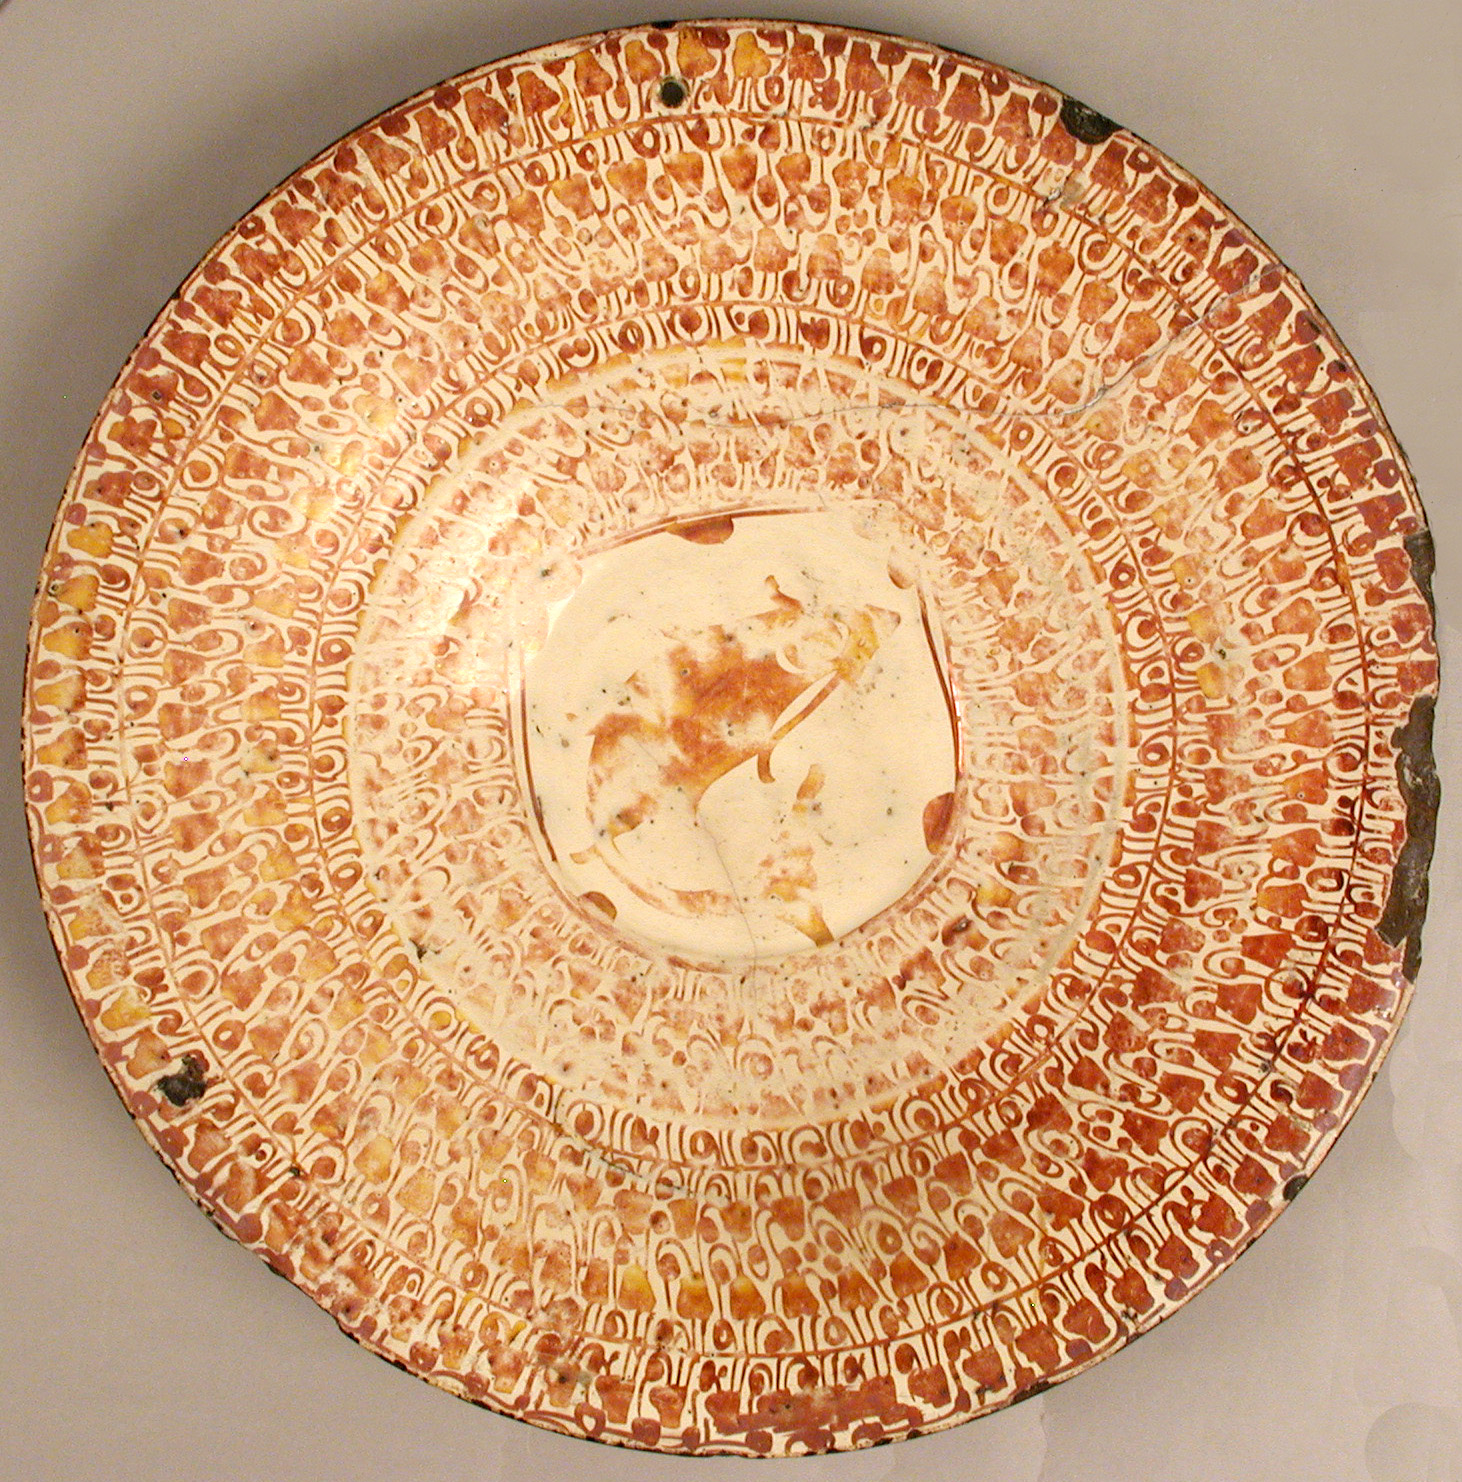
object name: dish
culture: spanish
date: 1401-1500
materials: earthenware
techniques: glazing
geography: spain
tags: fish